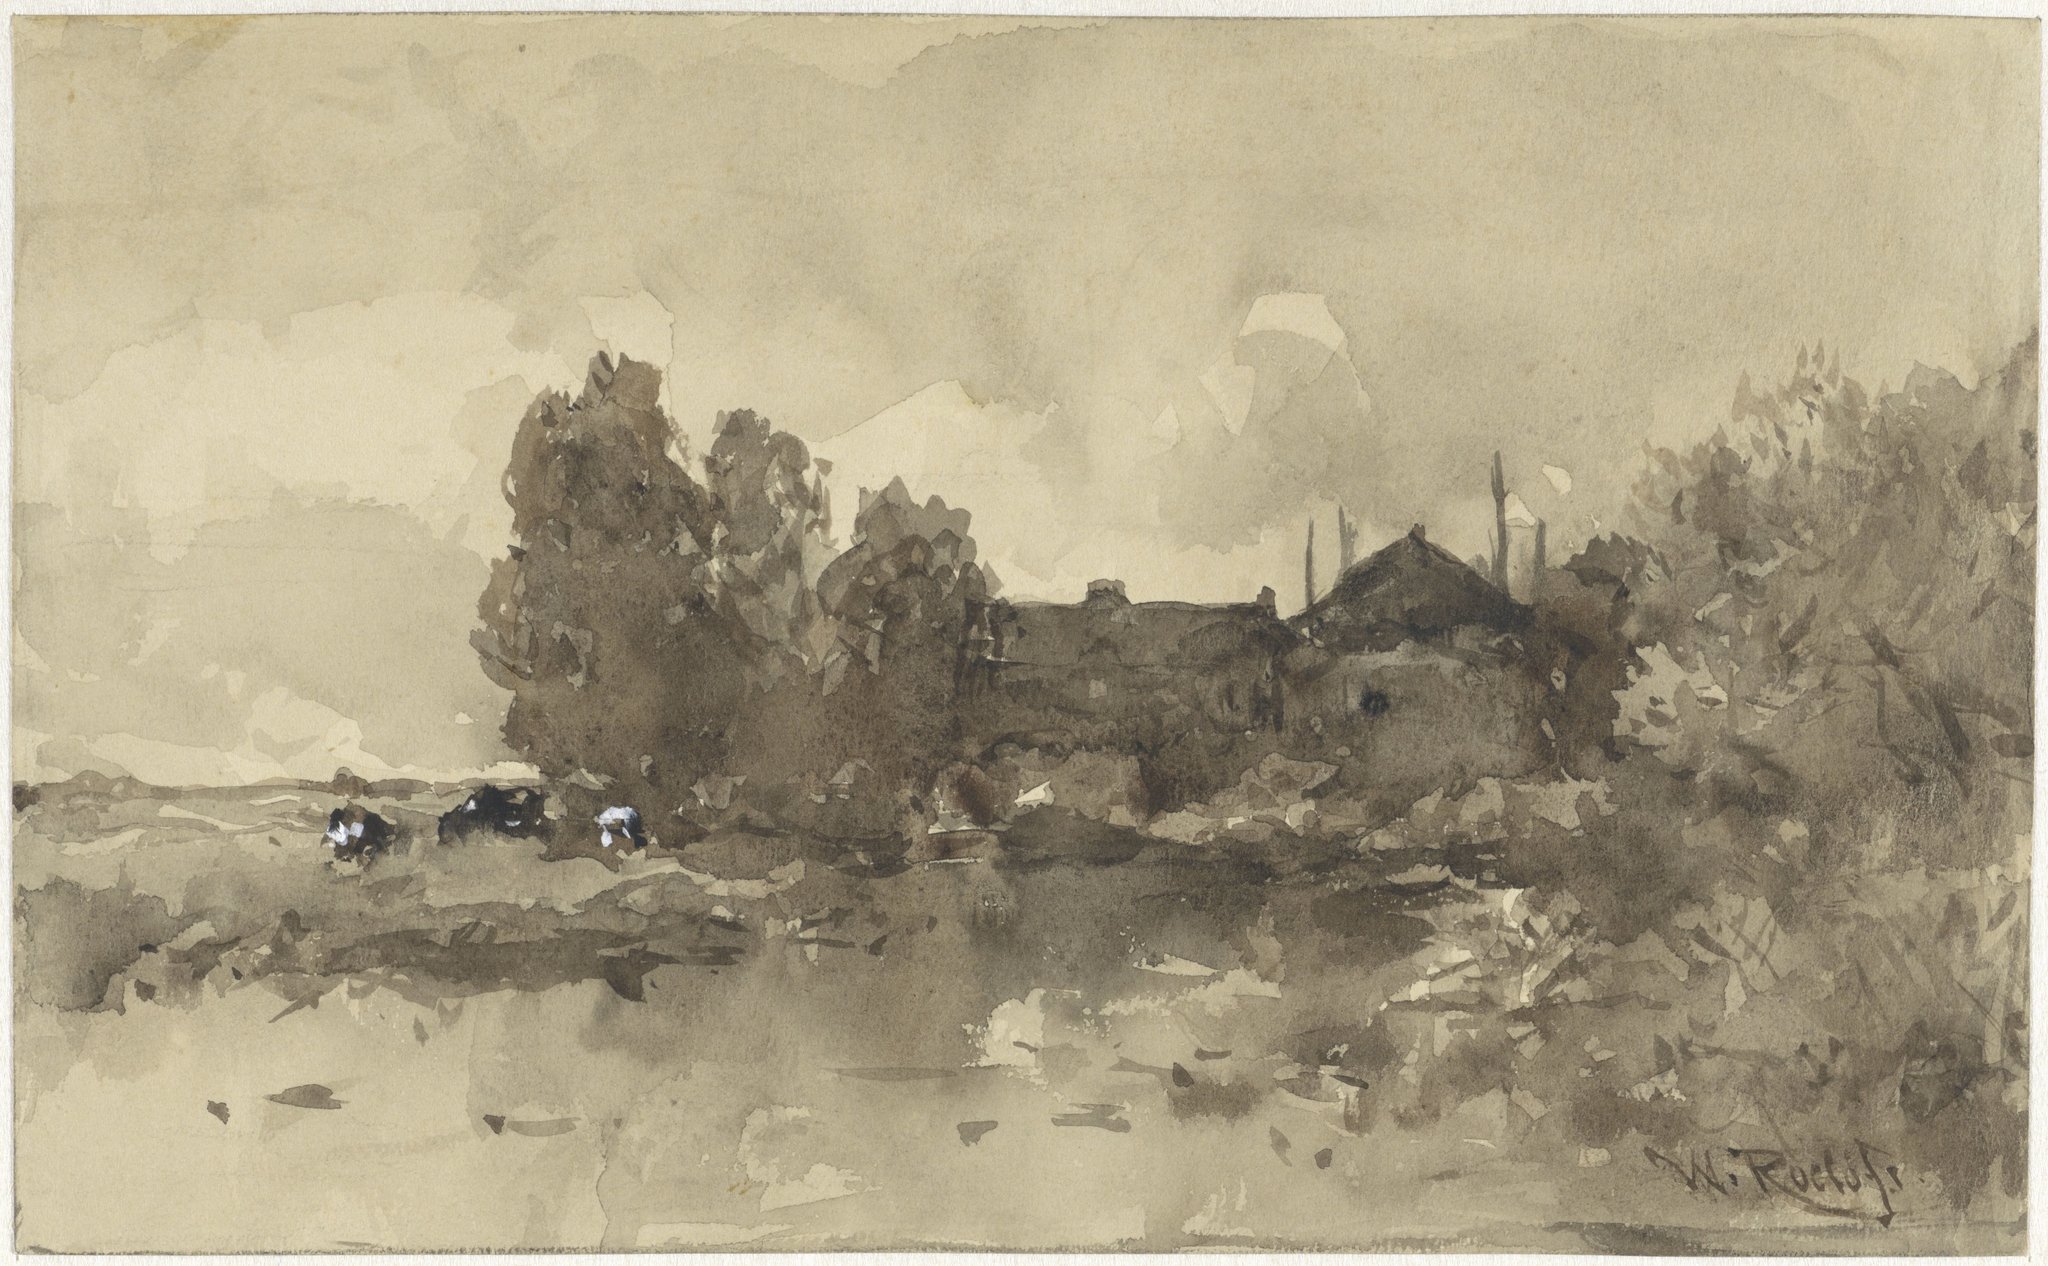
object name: drawing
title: Landschap met boerderij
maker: willem roelofs (i)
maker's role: draughtsman, painter, print maker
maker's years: 1822-1897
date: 1832-1897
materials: paper, pencil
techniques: brush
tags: farm or solitary house in landscape